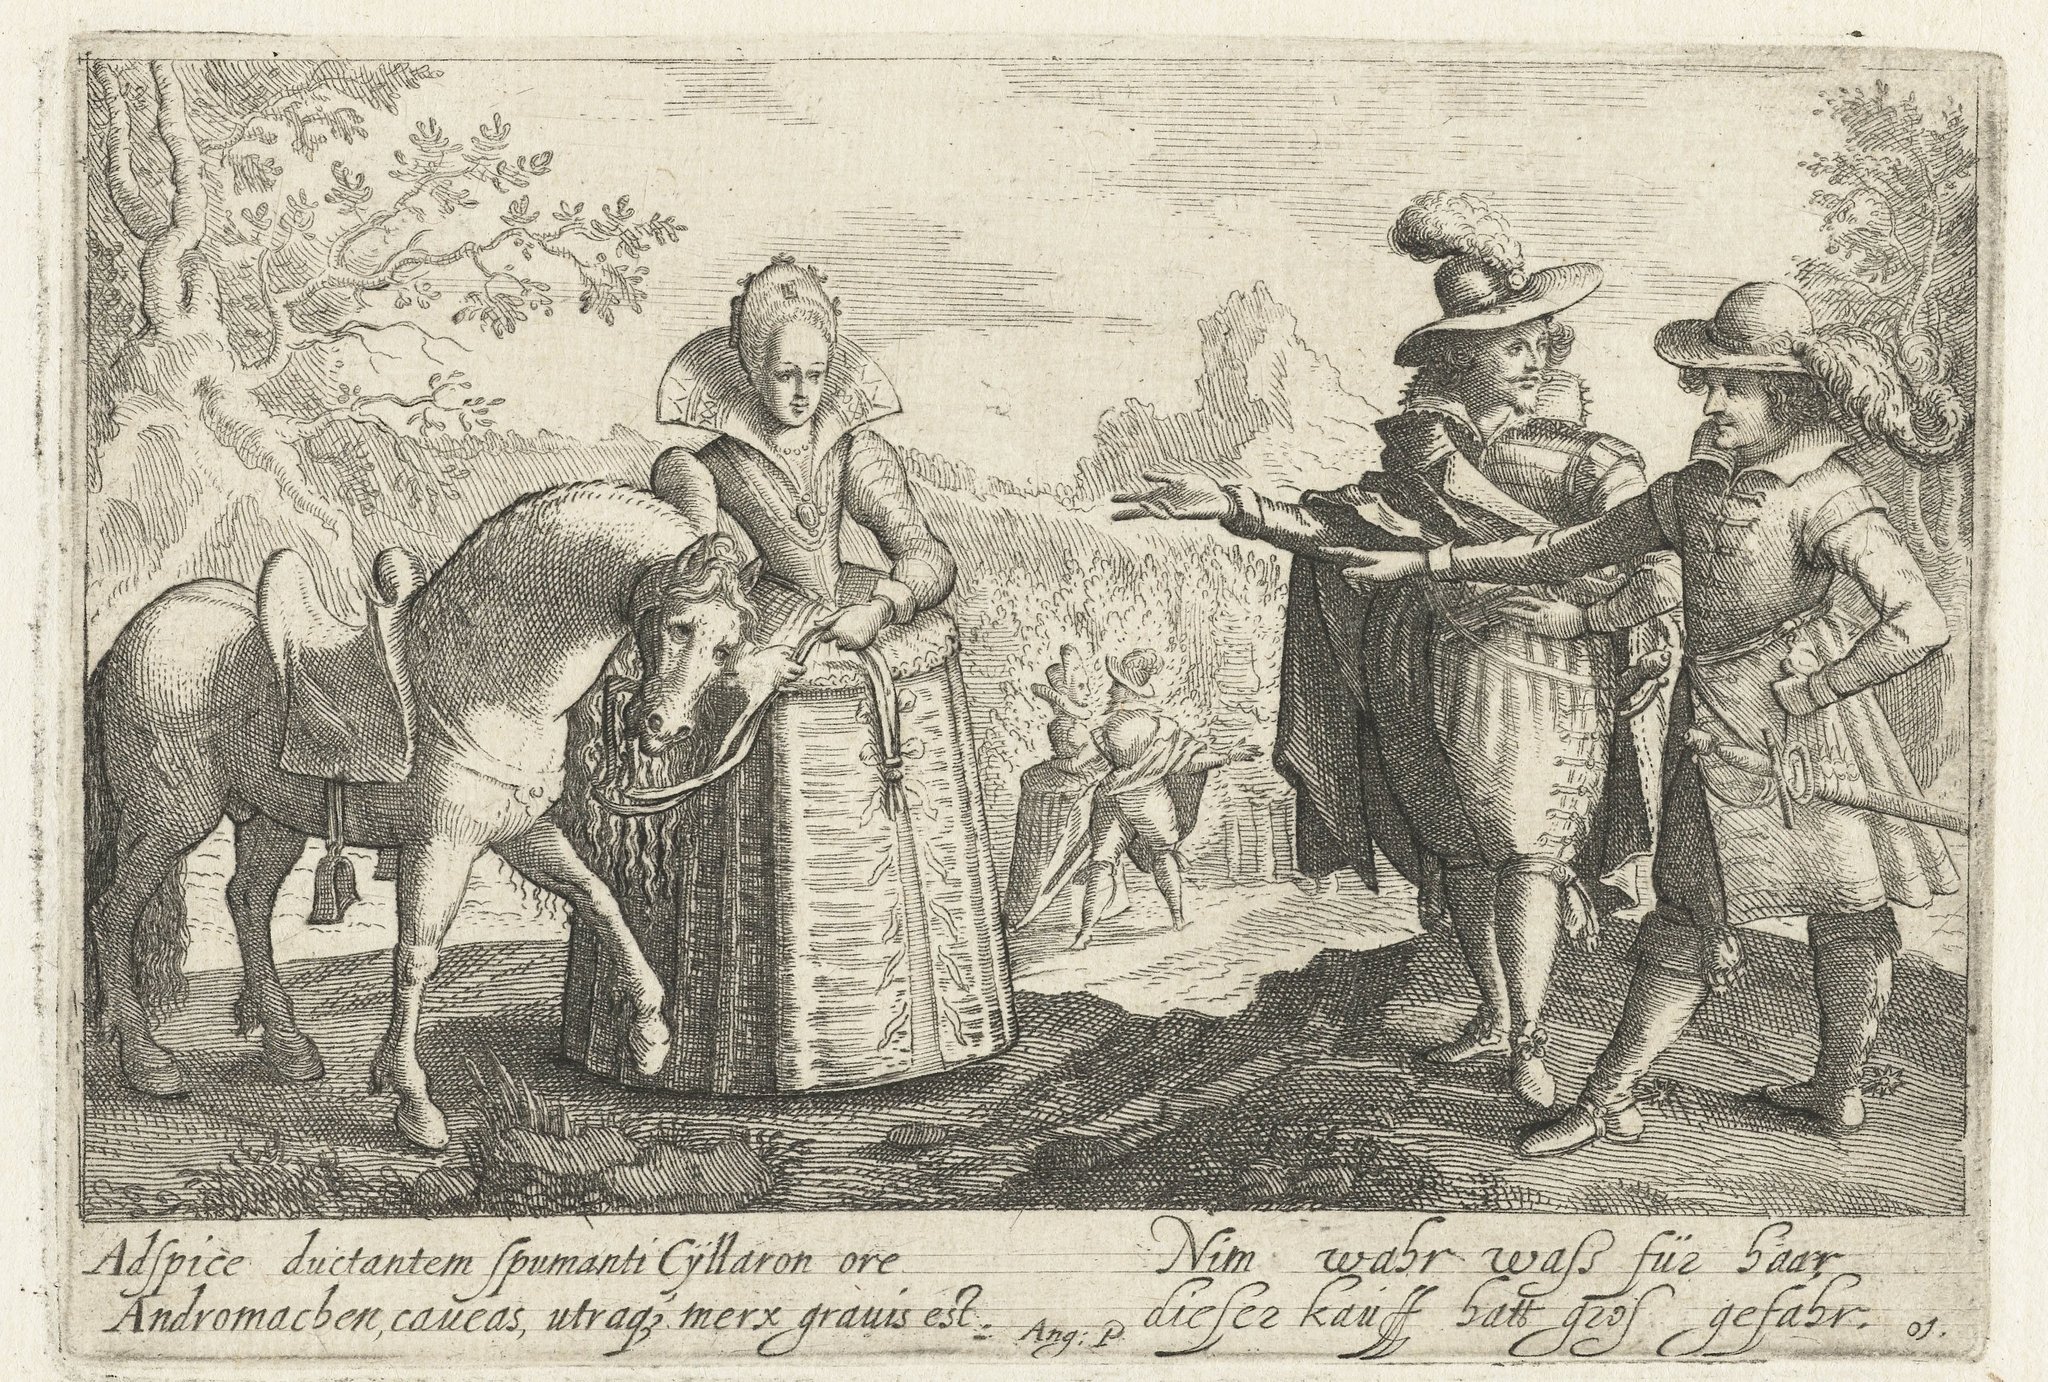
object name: print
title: Allegorie op de onbedachtzame huwelijkskeuze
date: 1608-1618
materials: paper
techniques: engraving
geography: straatsburg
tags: 'album amicorum', 'stammbuch', morality, horse, betrothal and marriage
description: Deze serie, getiteld ‘Pugillus facetiarum iconographicarum in studiosorum (…)’, bestond vermoedelijk uit 36 of meer prenten. Van deze serie zijn in ieder geval twee uitgaven bekend, uit 1608 en 1618. De prenten uit deze serie in de collectie van het Rijksmuseum (RP-P-1996-1 t/m RP-P-1996-36) zijn vermoedelijk afkomstig uit verschillende uitgaven, of uit de tweede uitgave. De inhoud van beide uitgaven verschilt, maar om de precieze inhoud van de verschillende uitgaven vast te stellen is meer onderzoek nodig. Er zijn geen volledige exemplaren van de eerste uitgave bekend. Aan de hand van de analyse van een andere serie, ‘Jeucht spieghel’,* die kopieën van ‘Pugillus’ bevat en is uitgegeven in 1610 én de aanwezige exemplaren van prenten uit ‘Pugillus’ in een inmiddels verloren album amicorum uit 1610,** kan in ieder geval van een aantal prenten gesteld worden dat ze al voorkwamen in de uitgave van 1608. Dit geldt voor RP-P-1996-1 (de titelprent), RP-P-1996-5, RP-P-1996-6, RP-P-1996-7, RP-P-1996-8, RP-P-1996-9, RP-P-1996-10, RP-P-1996-11, RP-P-1996-12, RP-P-1996-13, RP-P-1996-14, RP-P-1996-15, RP-P-1996-16, RP-P-1996-17, RP-P-1996-18, RP-P-1996-19, RP-P-1996-24, RP-P-1996-28, RP-P-1996-29, RP-P-1996-33 en RP-P-1996-35. Van één prent (RP-P-1996-31) kan vastgesteld worden dat die pas in de latere uitgave van 1618 voorkwam, omdat het kopie is van een prent uit weer een andere serie, ‘Academia sive speculum vitae scholasticae (…)’, die werd uitgegeven in 1612.*** Deze prent kwam al voor in de uitgave van 1608. Dit blijkt uit ‘Jeucht spieghel’* en het album amicorum.** * Z.G.H.P.H.S [Zacharias Heyns]. Jeucht spieghel. S.l.s.n., 1610. Voor een gedigitaliseerd exemplaar zie: https://archive.org/details/ned-kbn-all-00000628-001/page/n9/mode/2up. ** Zie: Erman, Wilhelm en Ewald Horn. Bibliographie der deutschen Universitäten, systematisch geordnetes Verzeichnis der bis Ende 1899 gedruckten Bücher und Aufsätze über das deutsche Universitätswesen. Leipzig en Berlijn: Verlag von B.G. Teubner, 1904, dl. 1, p. 826-832, no. 17328. https://archive.org/details/bibliographieder01ermauoft/page/826/mode/2up *** Passe, Crispijn van de (I). Academia sive speculum vitae scholasticae (…). Arnhem: Johannes Janssonius [Jan Jansz.], 1612. Voor een gedigitaliseerd exemplaar zie: http://gallica.bnf.fr/ark:/12148/btv1b55005974h.